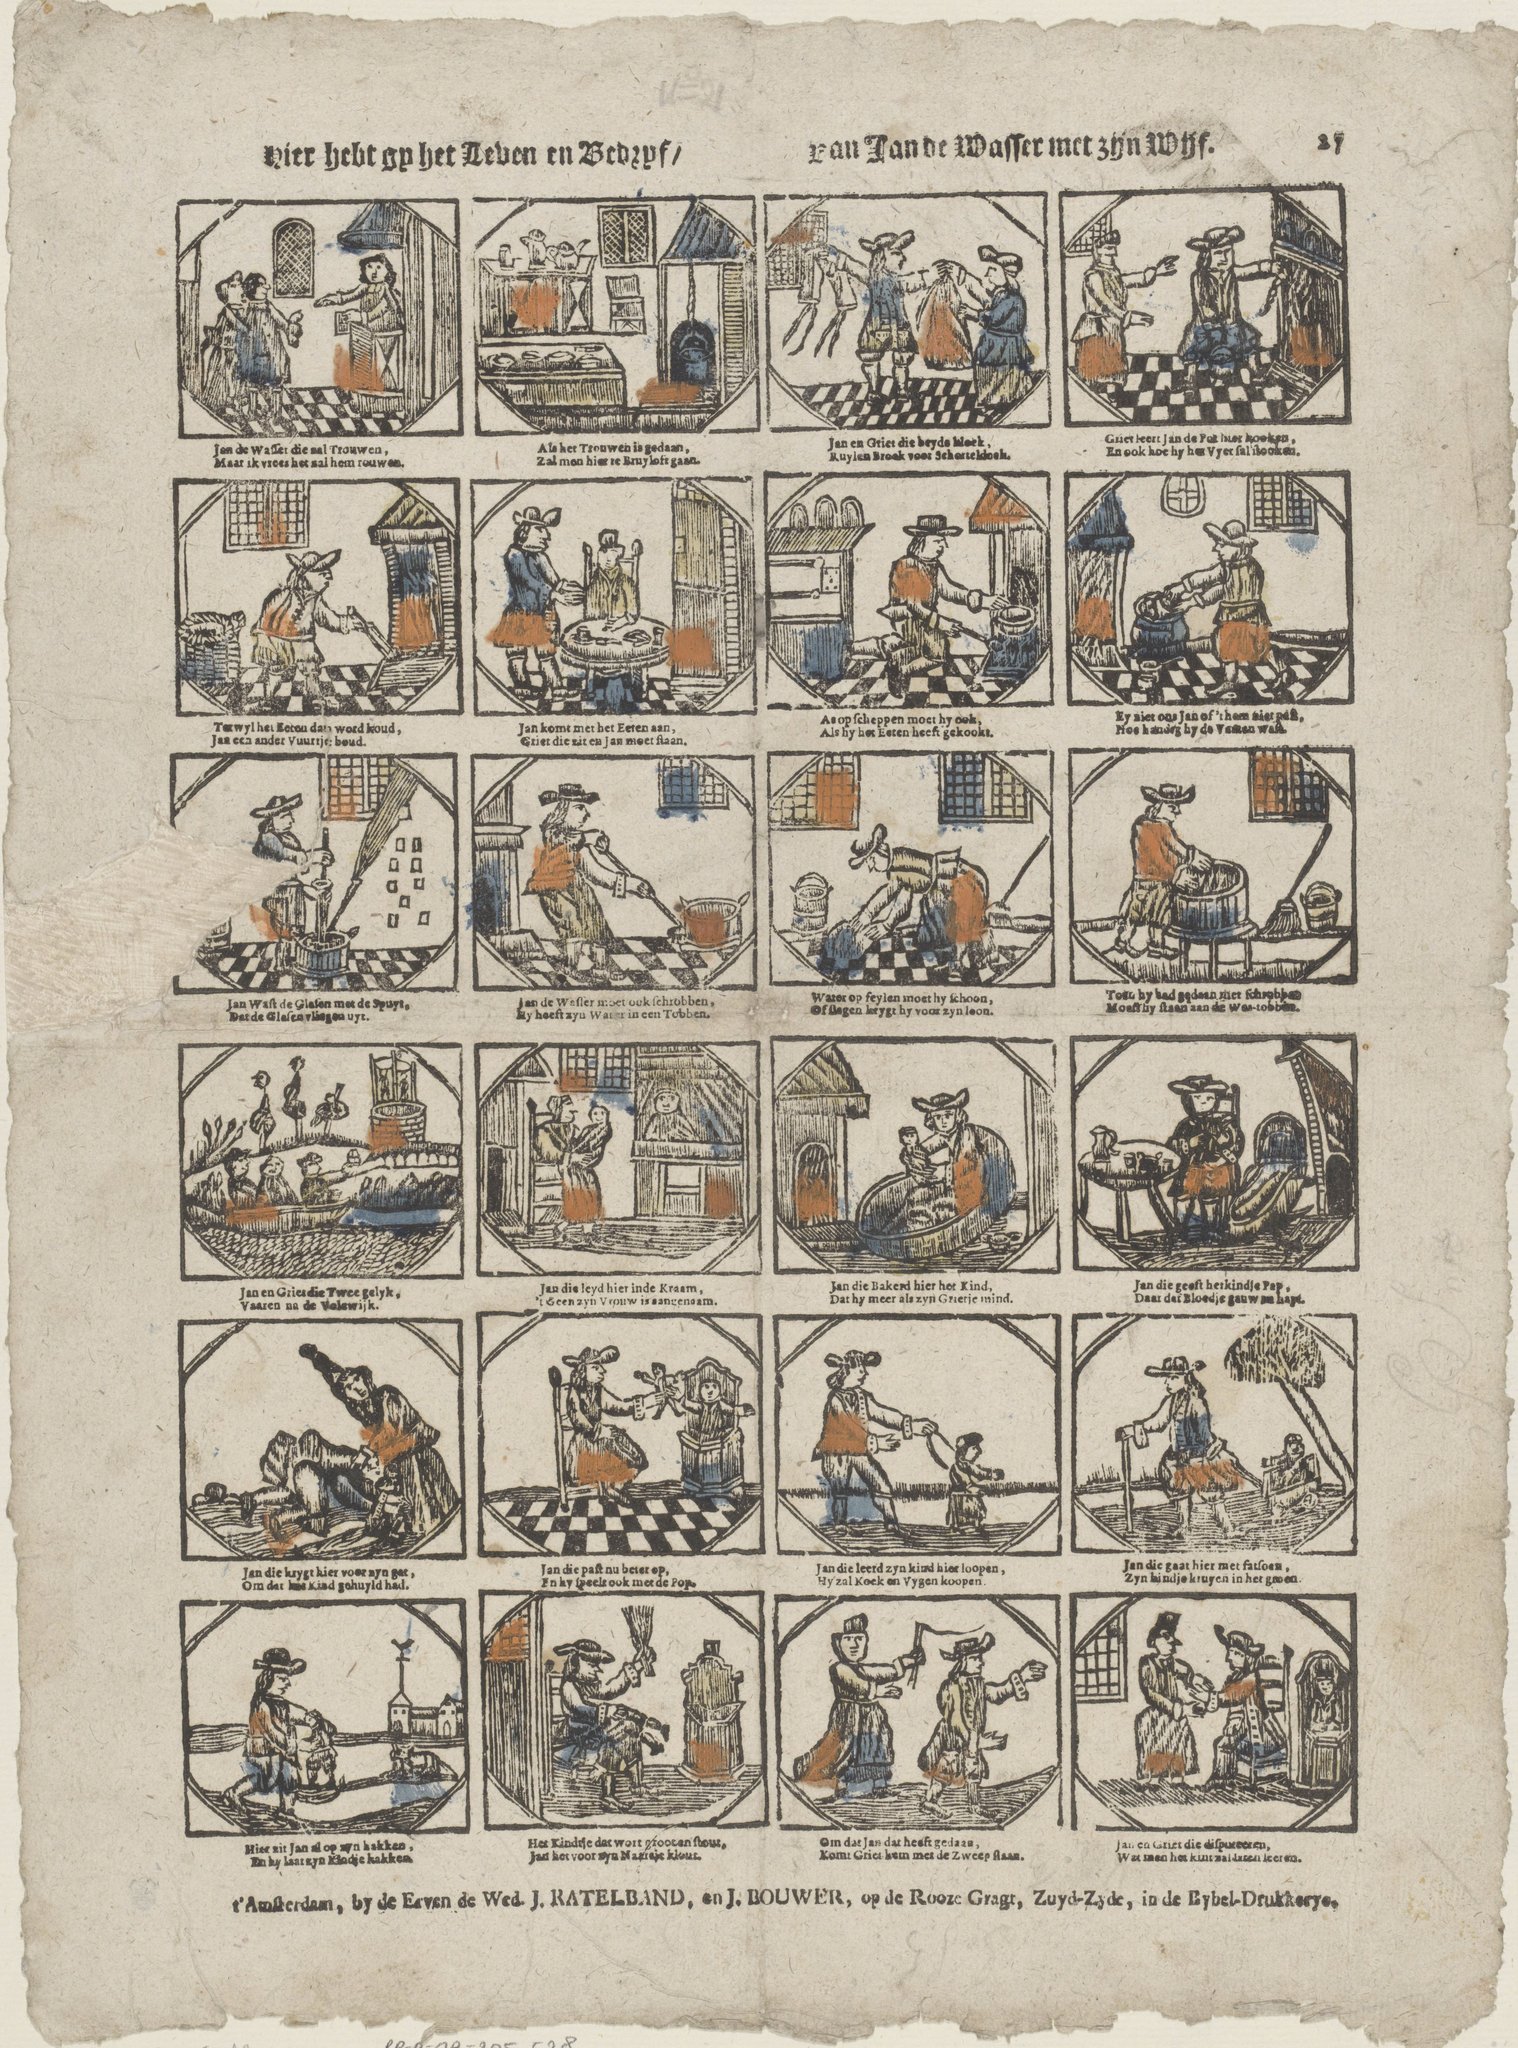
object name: print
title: Hier hebt gy het leven en bedryf / Van Jan de Wasser met zyn wyf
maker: Anonymous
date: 1782-1793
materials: paper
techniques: colour, letterpress printing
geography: netherlands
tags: hen-pecked husband, 'betty', 'molly' (man who engages in women's work)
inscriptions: collector's mark: Lugt 2760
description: Blad met 24 voorstellingen uit het leven van Jan de Wasser, een man die van zijn vrouw Griet, die de broek aan heeft, al het huishoudelijk werk moet doen. Onder elke afbeelding een tweeregelig vers. Genummerd rechtsboven: 27.